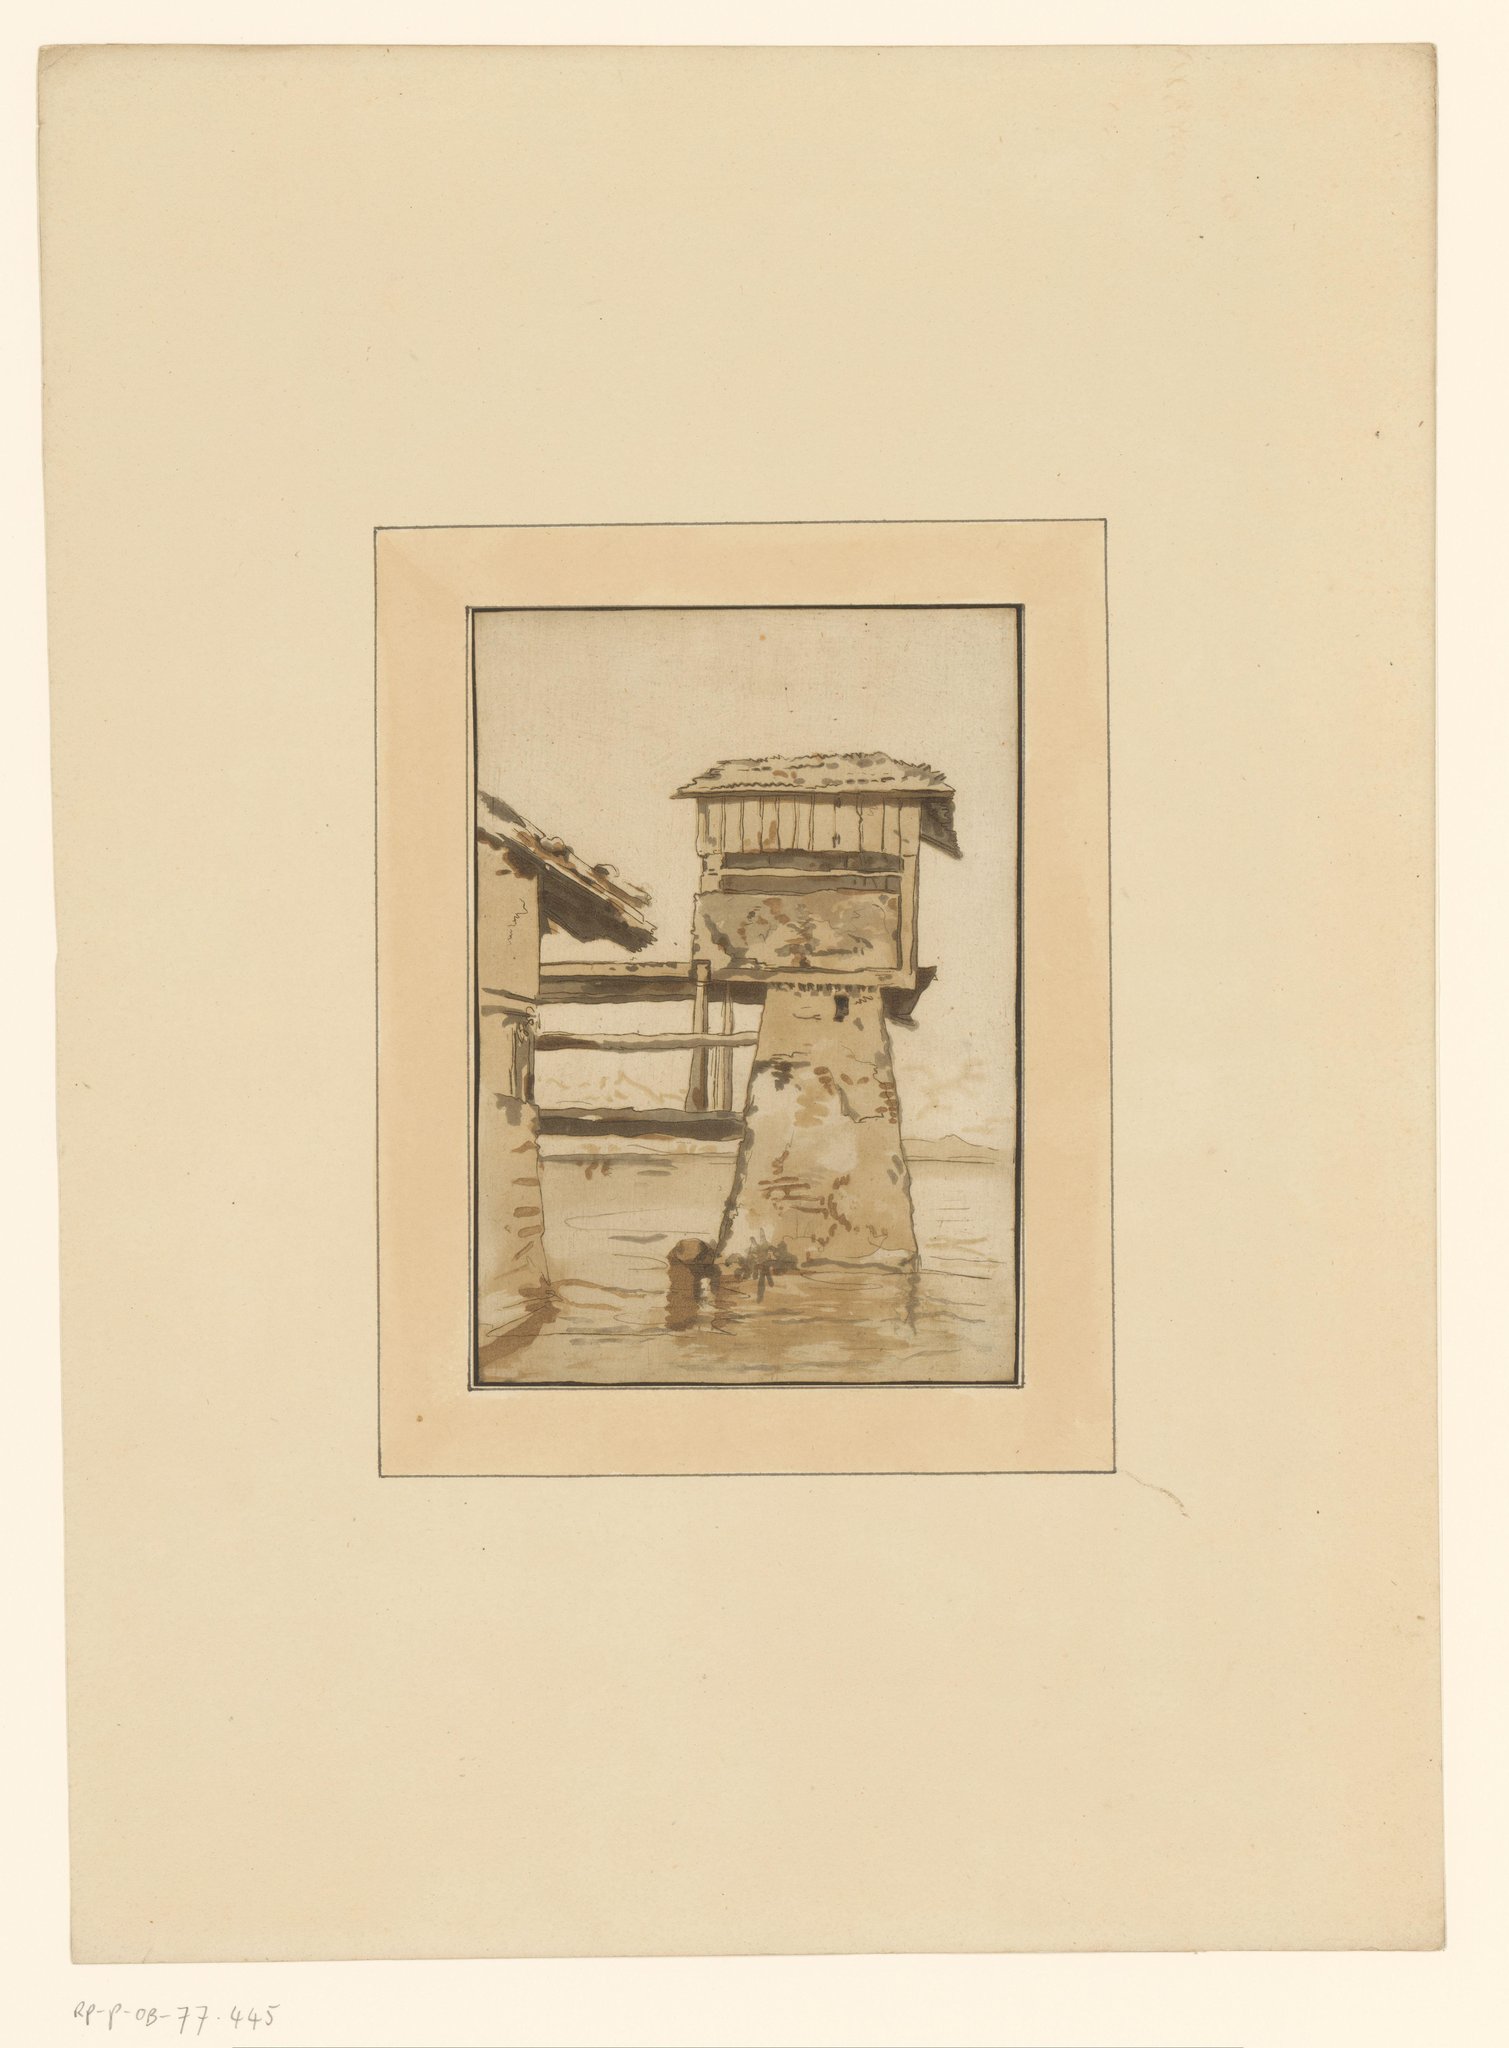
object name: print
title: Zwitserse boerderij aan een meer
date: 1783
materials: paper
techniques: etching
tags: farm or solitary house in landscape, switzerland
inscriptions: collector's mark: Lugt 2228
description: Nummer 20 uit het prentenalbum 'Dessins des meilleurs Peintres d'Italie, d'Allemagne, et des Pays-Bas, Tirés de divers célebres Cabinets. Gravés d'apres les Originaux de même grandeur par Jean Théophile Prestel'. Neurenberg: J.G. Prestel, 1783.